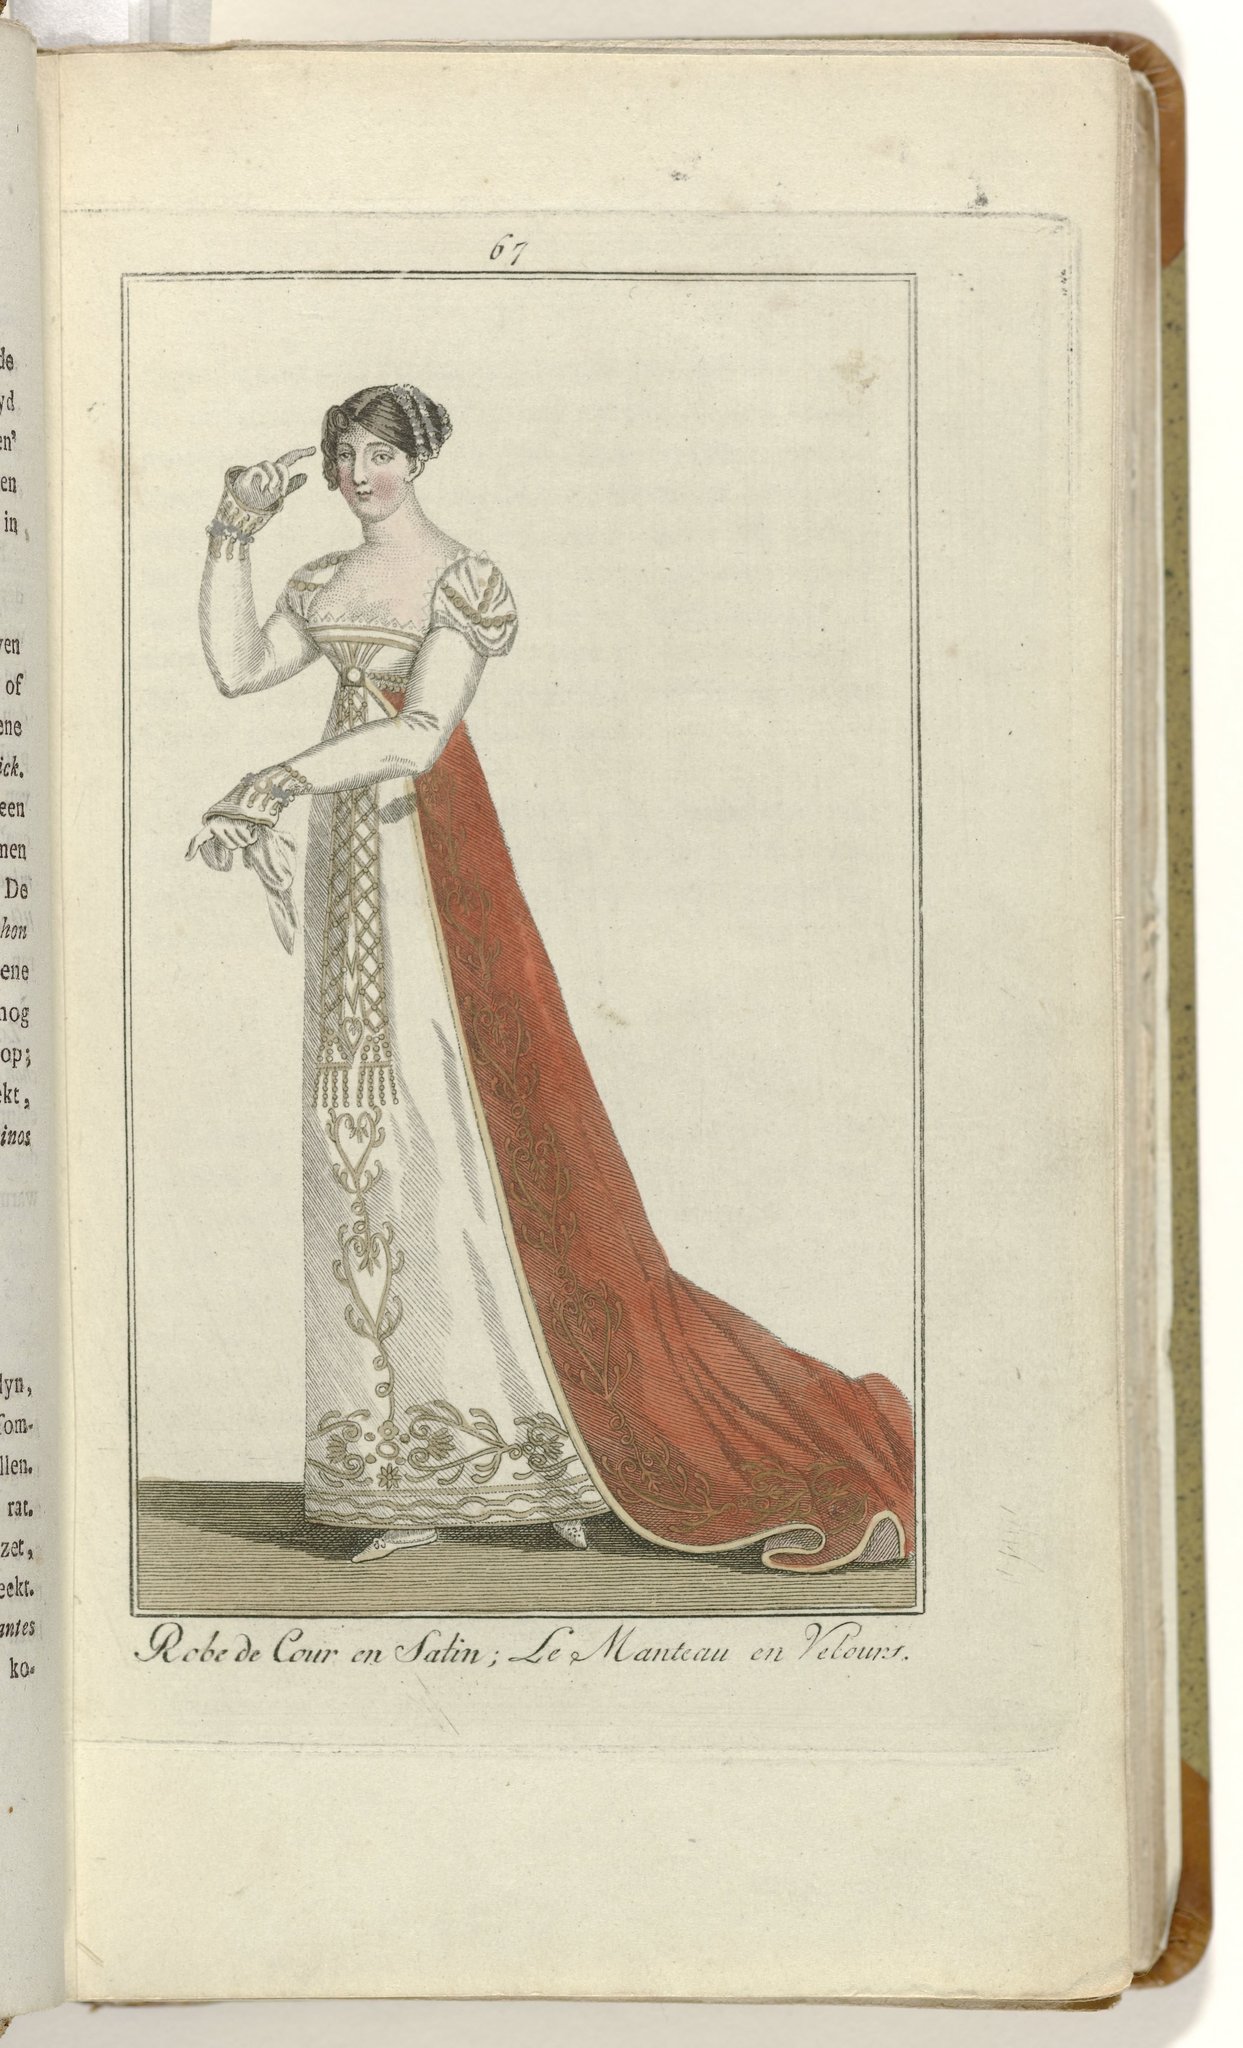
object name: magazine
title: Elegantia, of tijdschrift van mode, luxe en smaak voor dames, Januari 1809, No. 67: Robe de Cour en Satin...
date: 1809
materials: paper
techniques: engraving, hand coloring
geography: amsterdam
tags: gold-thread embroidery, dress, gown: court gown or court dress (+ women's clothes), handkerchief (+ women's clothes), styles of hairdress - aa - ~ women, fashion plates, bracelet, wristlet (+ women's clothes)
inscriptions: caption: ‘Robe de Cour en Satin; Le Manteau en Velours.’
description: Volgens de begeleidende tekst (p. 32): 'Grande parure'. Rood fluwelen mantel met goud geborduurd. 'Coëffure en diamans'. Toque van wit satijn (??). Diamanten armbanden. Volgens het onderschrift: Hofjapon van satijn. Mantel van fluweel. Prent uit het modetijdschrift Elegantia, of tijdschrift van mode, luxe en smaak voor dames 1807-1814 (onderbroken door de periode 1811-1813).